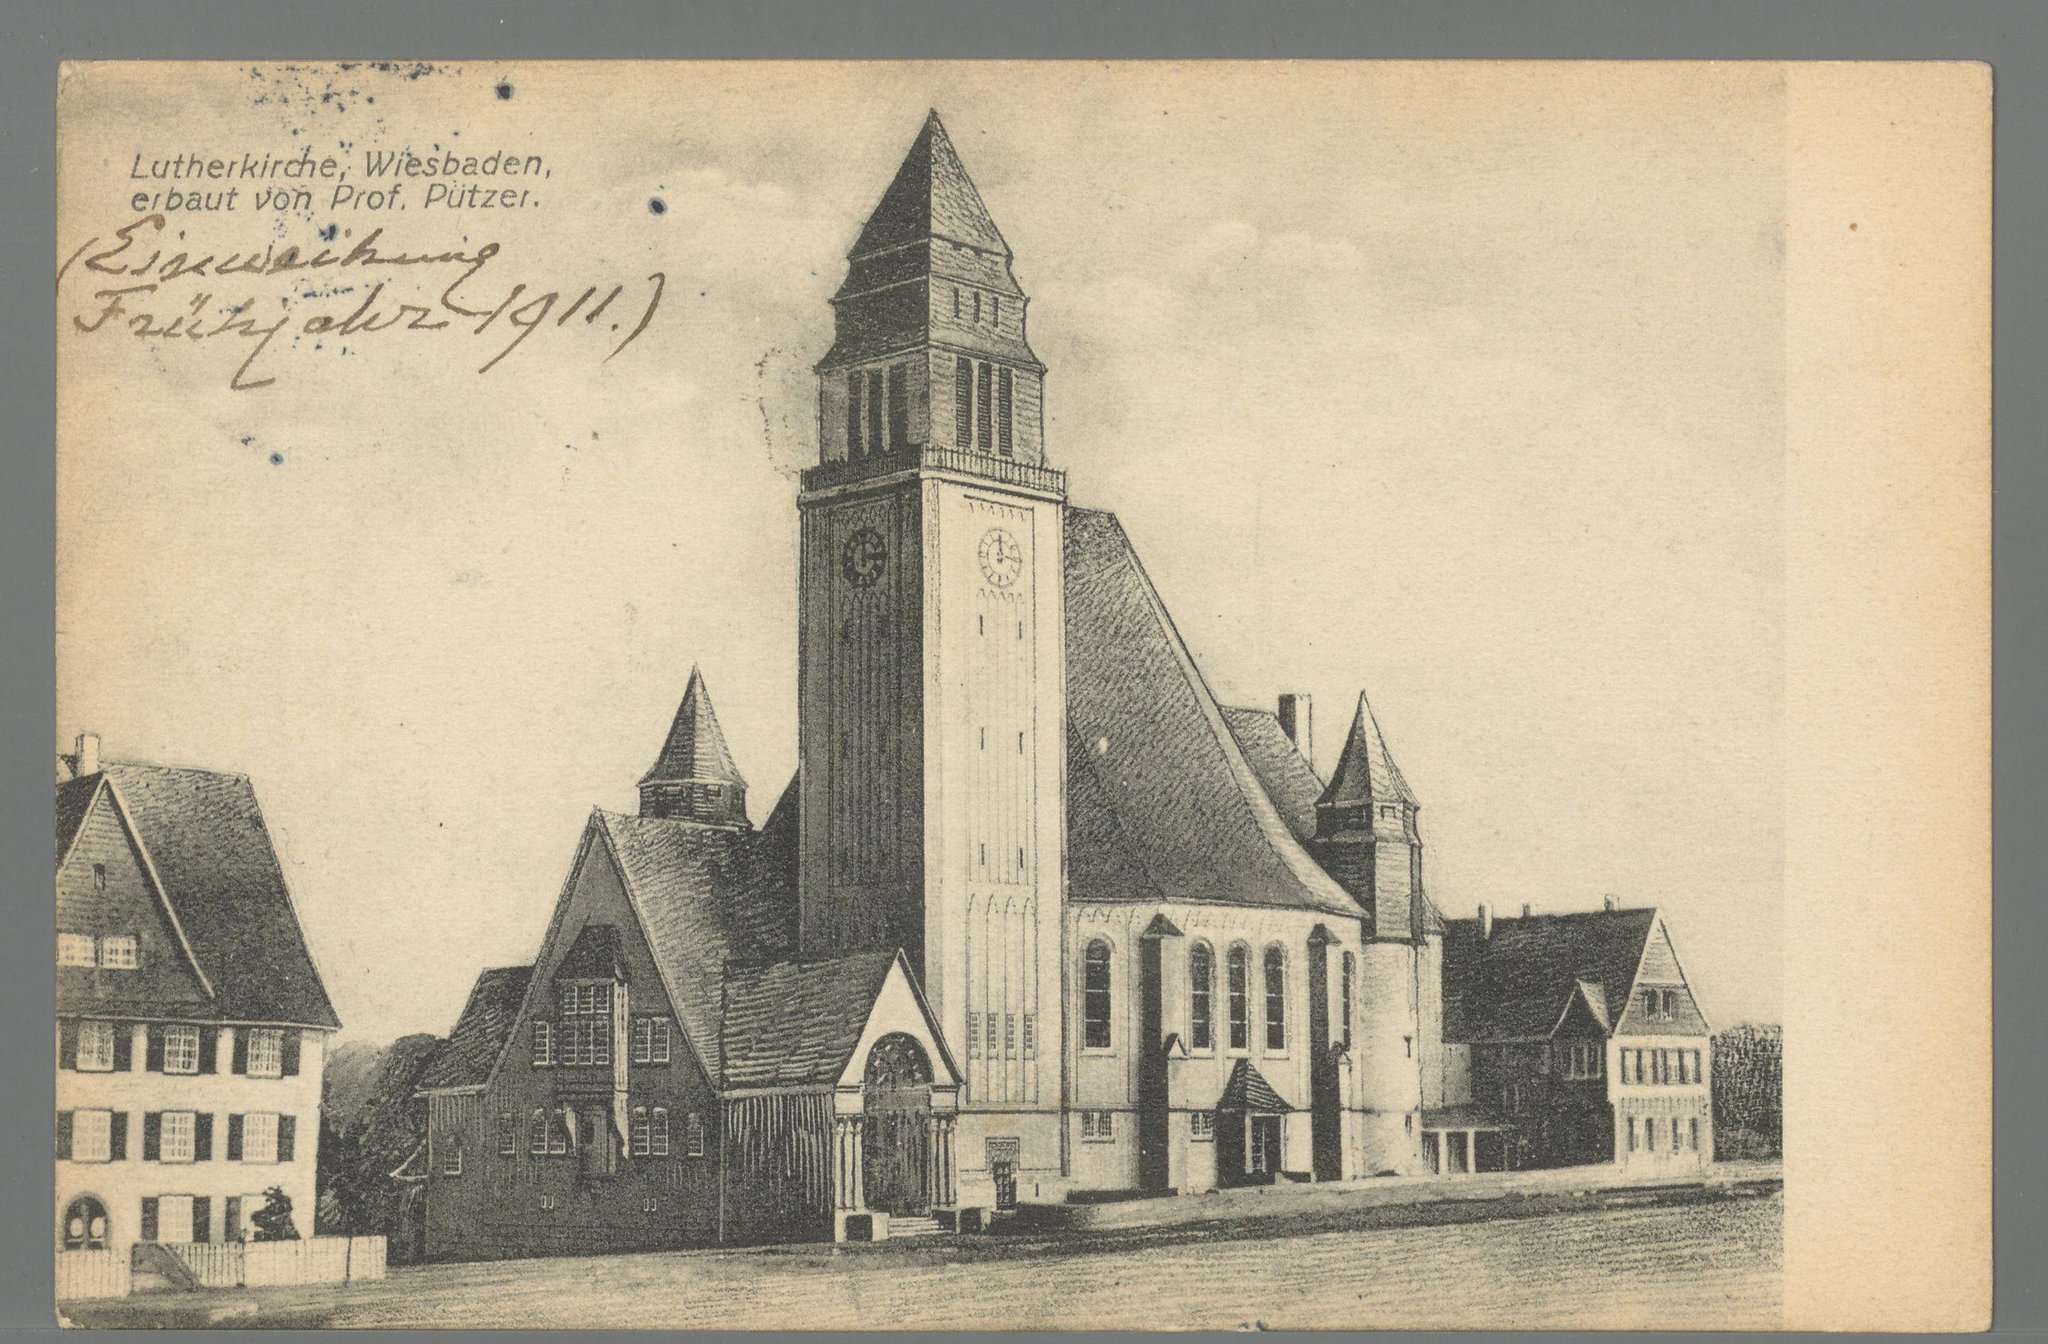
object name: photomechanical print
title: Lutherkirche, Wiesbaden, erbaut von Prof. Putzer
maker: Anonymous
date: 1905-1910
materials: cardboard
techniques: photograph, writing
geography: darmstadt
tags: church (exterior)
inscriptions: postage stamp